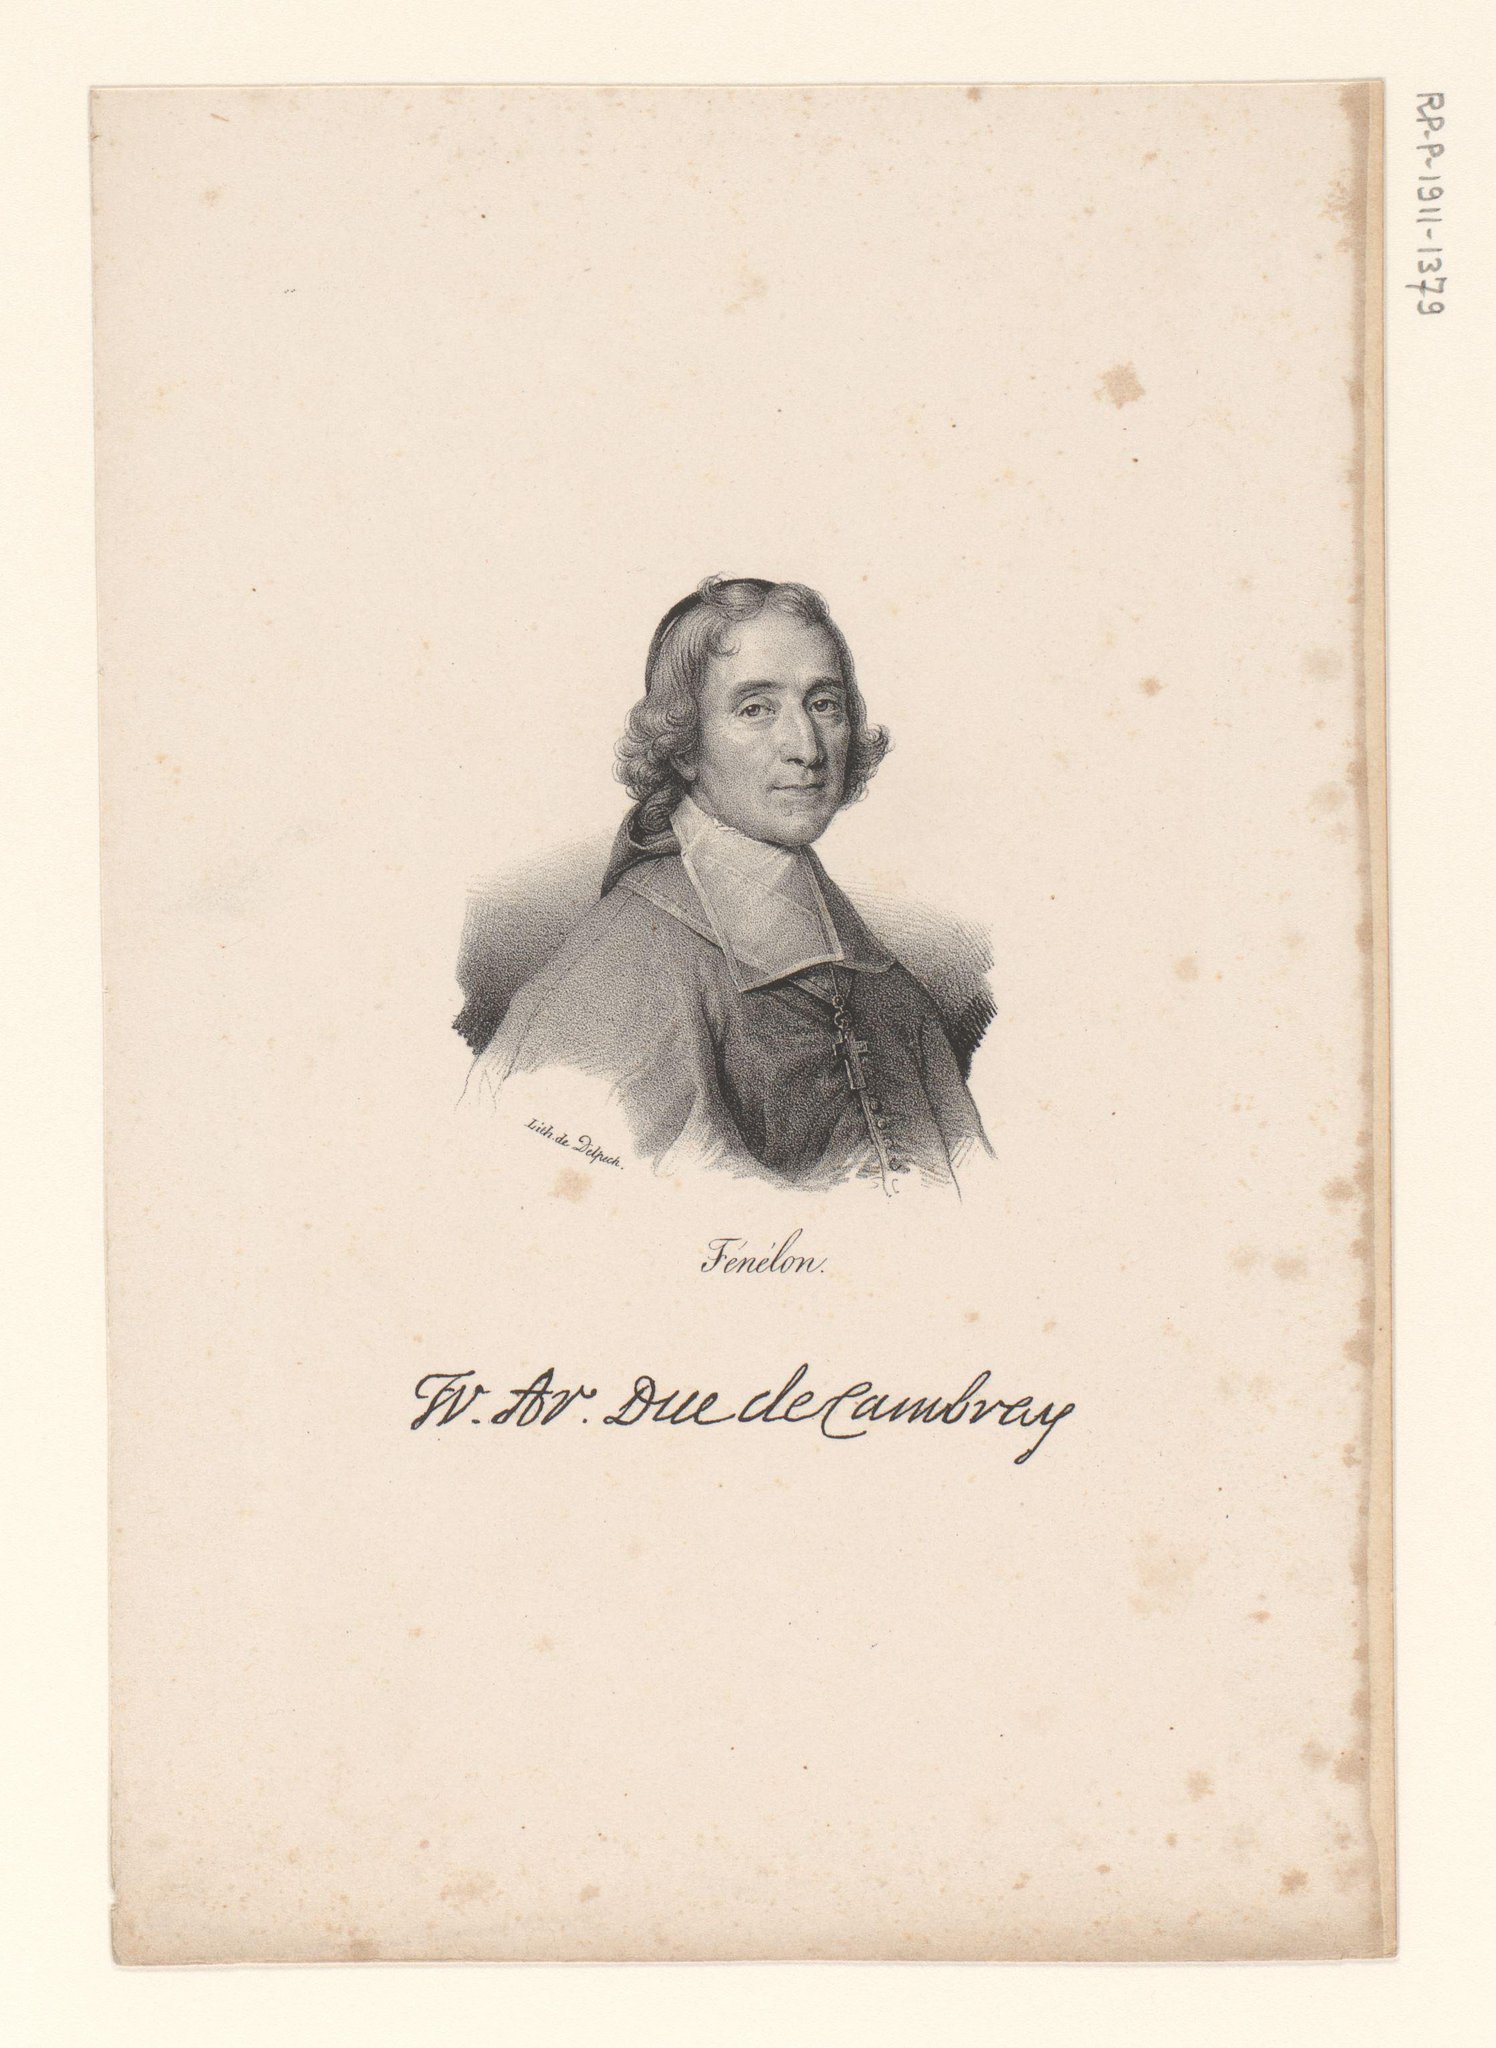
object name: print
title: Portret van François Fénelon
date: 1818-1842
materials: paper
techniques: lithograph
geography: paris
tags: françois fénelon, historical persons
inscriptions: collector's mark: Lugt 2228a